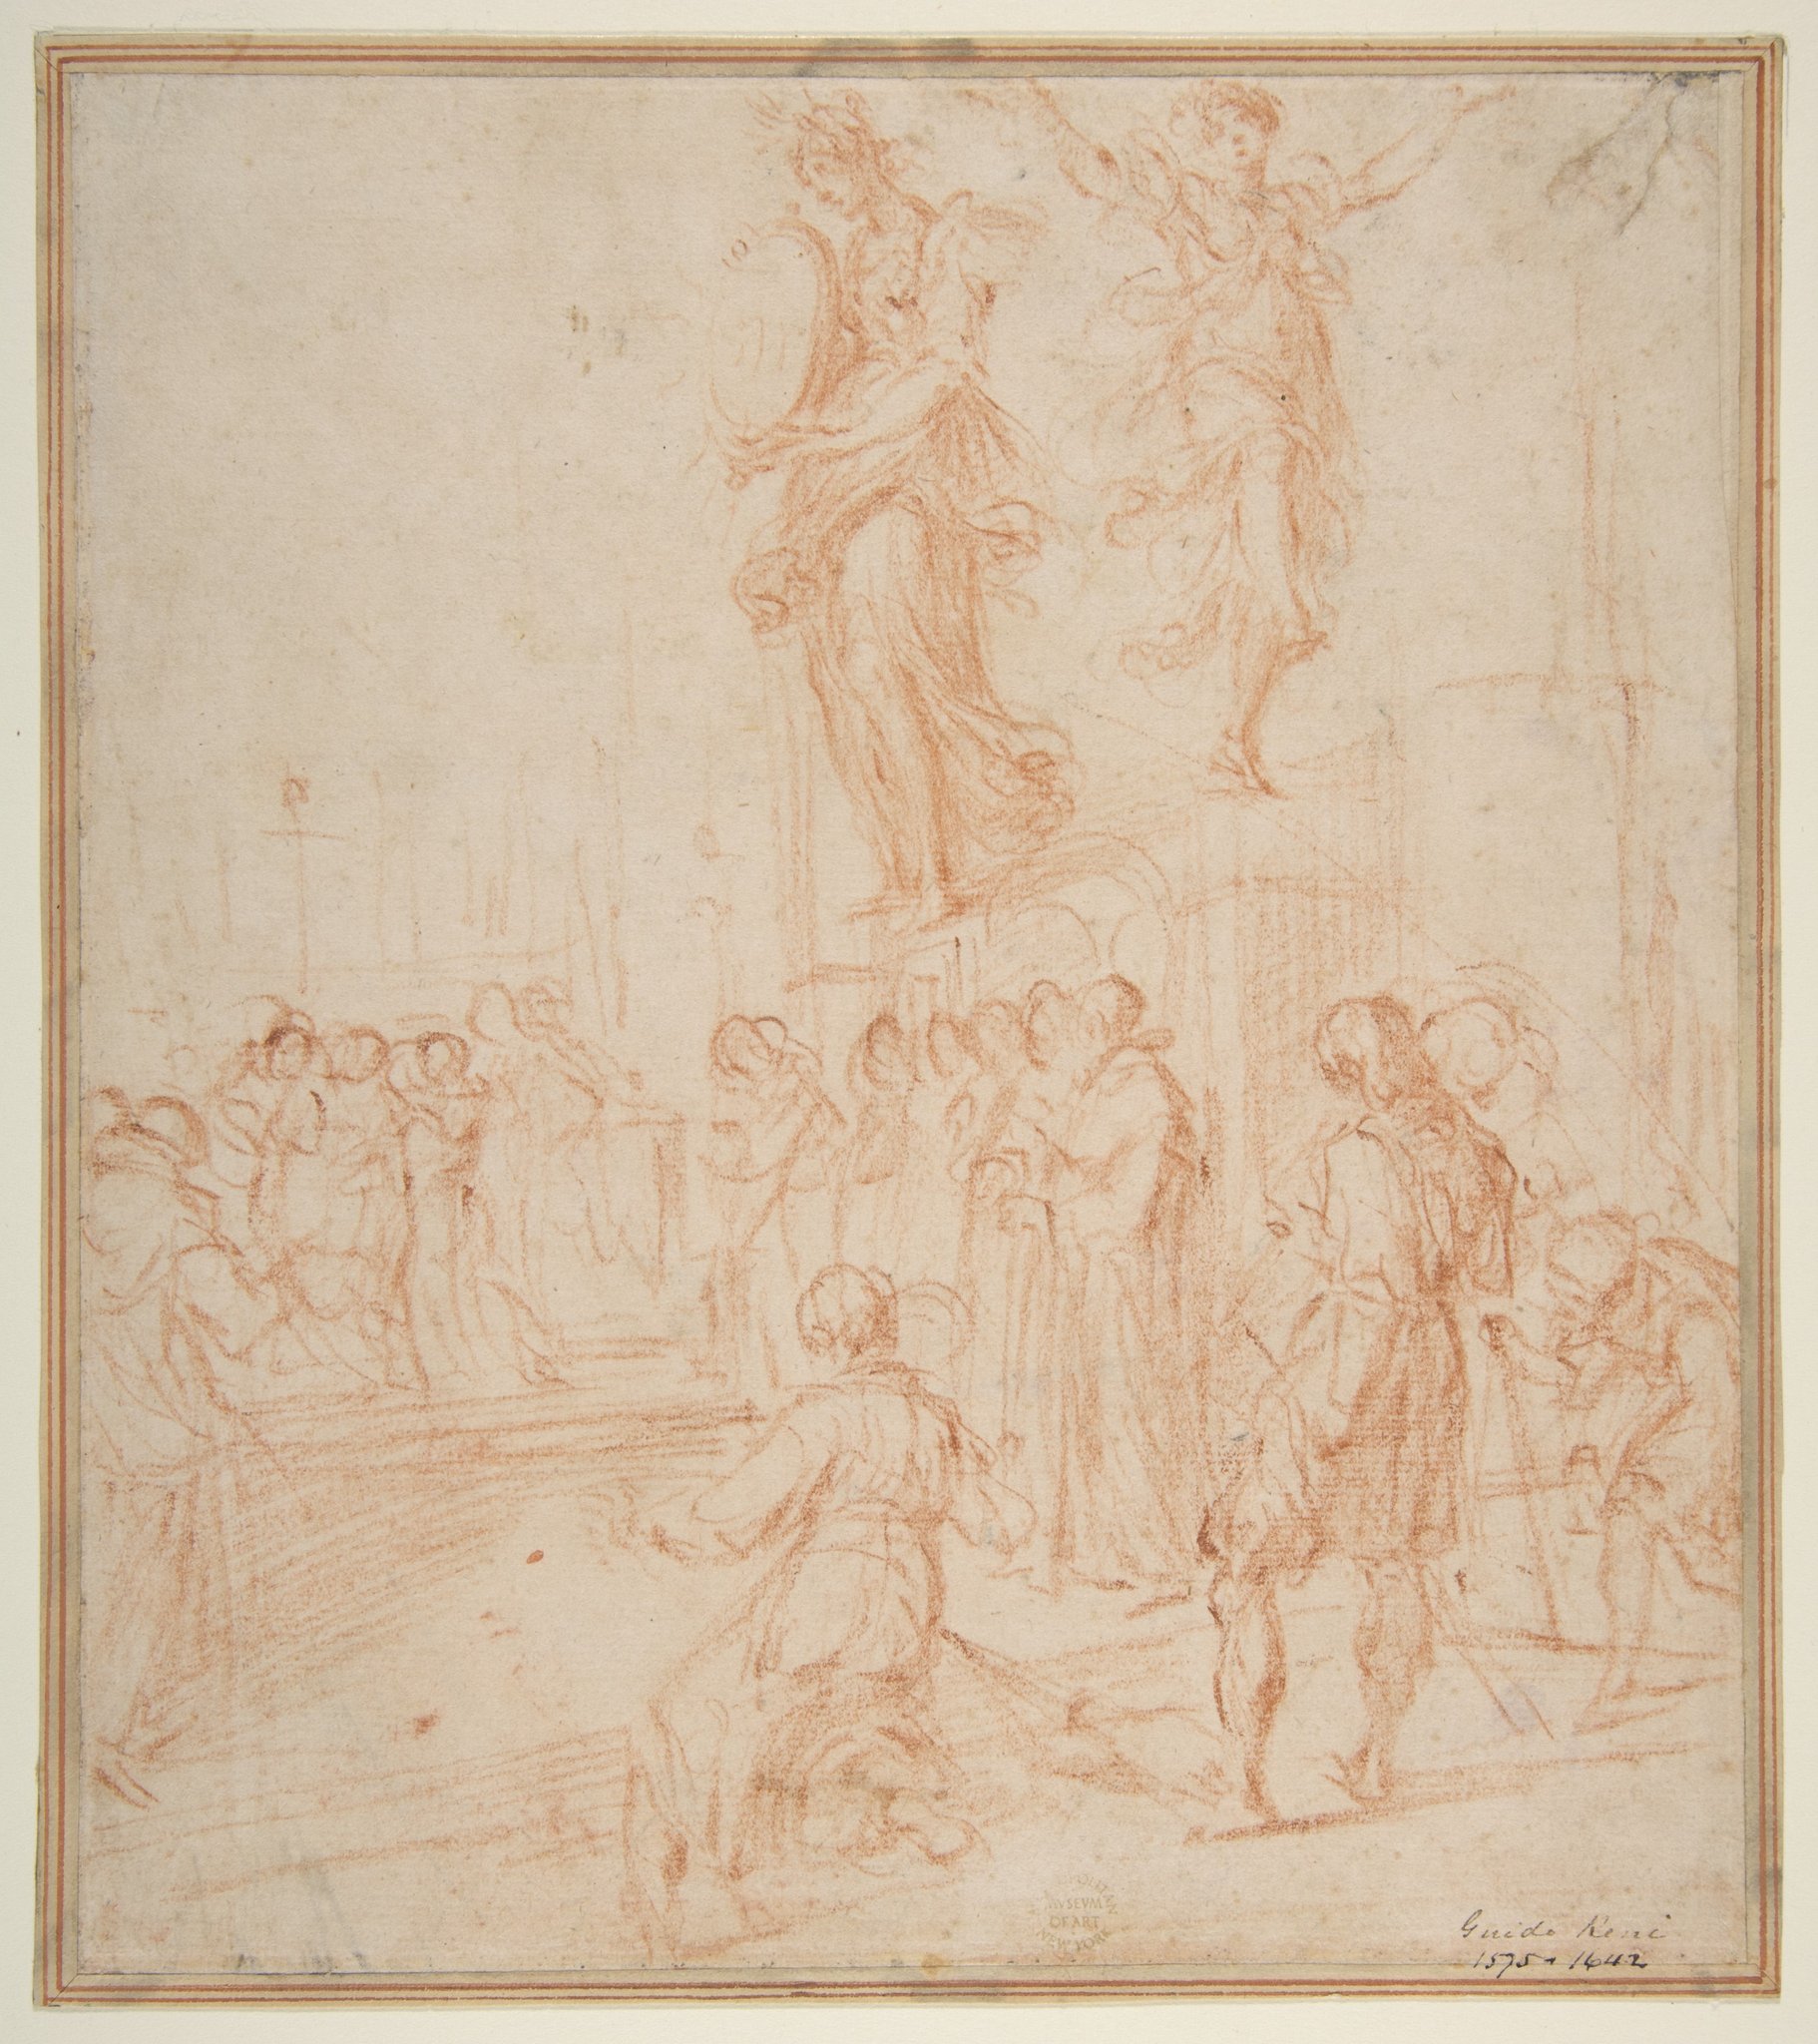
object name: drawing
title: Figure Studies: Woman holding a Shield, a Dancing Female, and a Priest Supported at an Altar before a Group of Onlookers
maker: bernardino poccetti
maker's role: artist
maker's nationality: italian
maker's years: 1548-1612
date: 1612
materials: chalk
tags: men,women,dancing